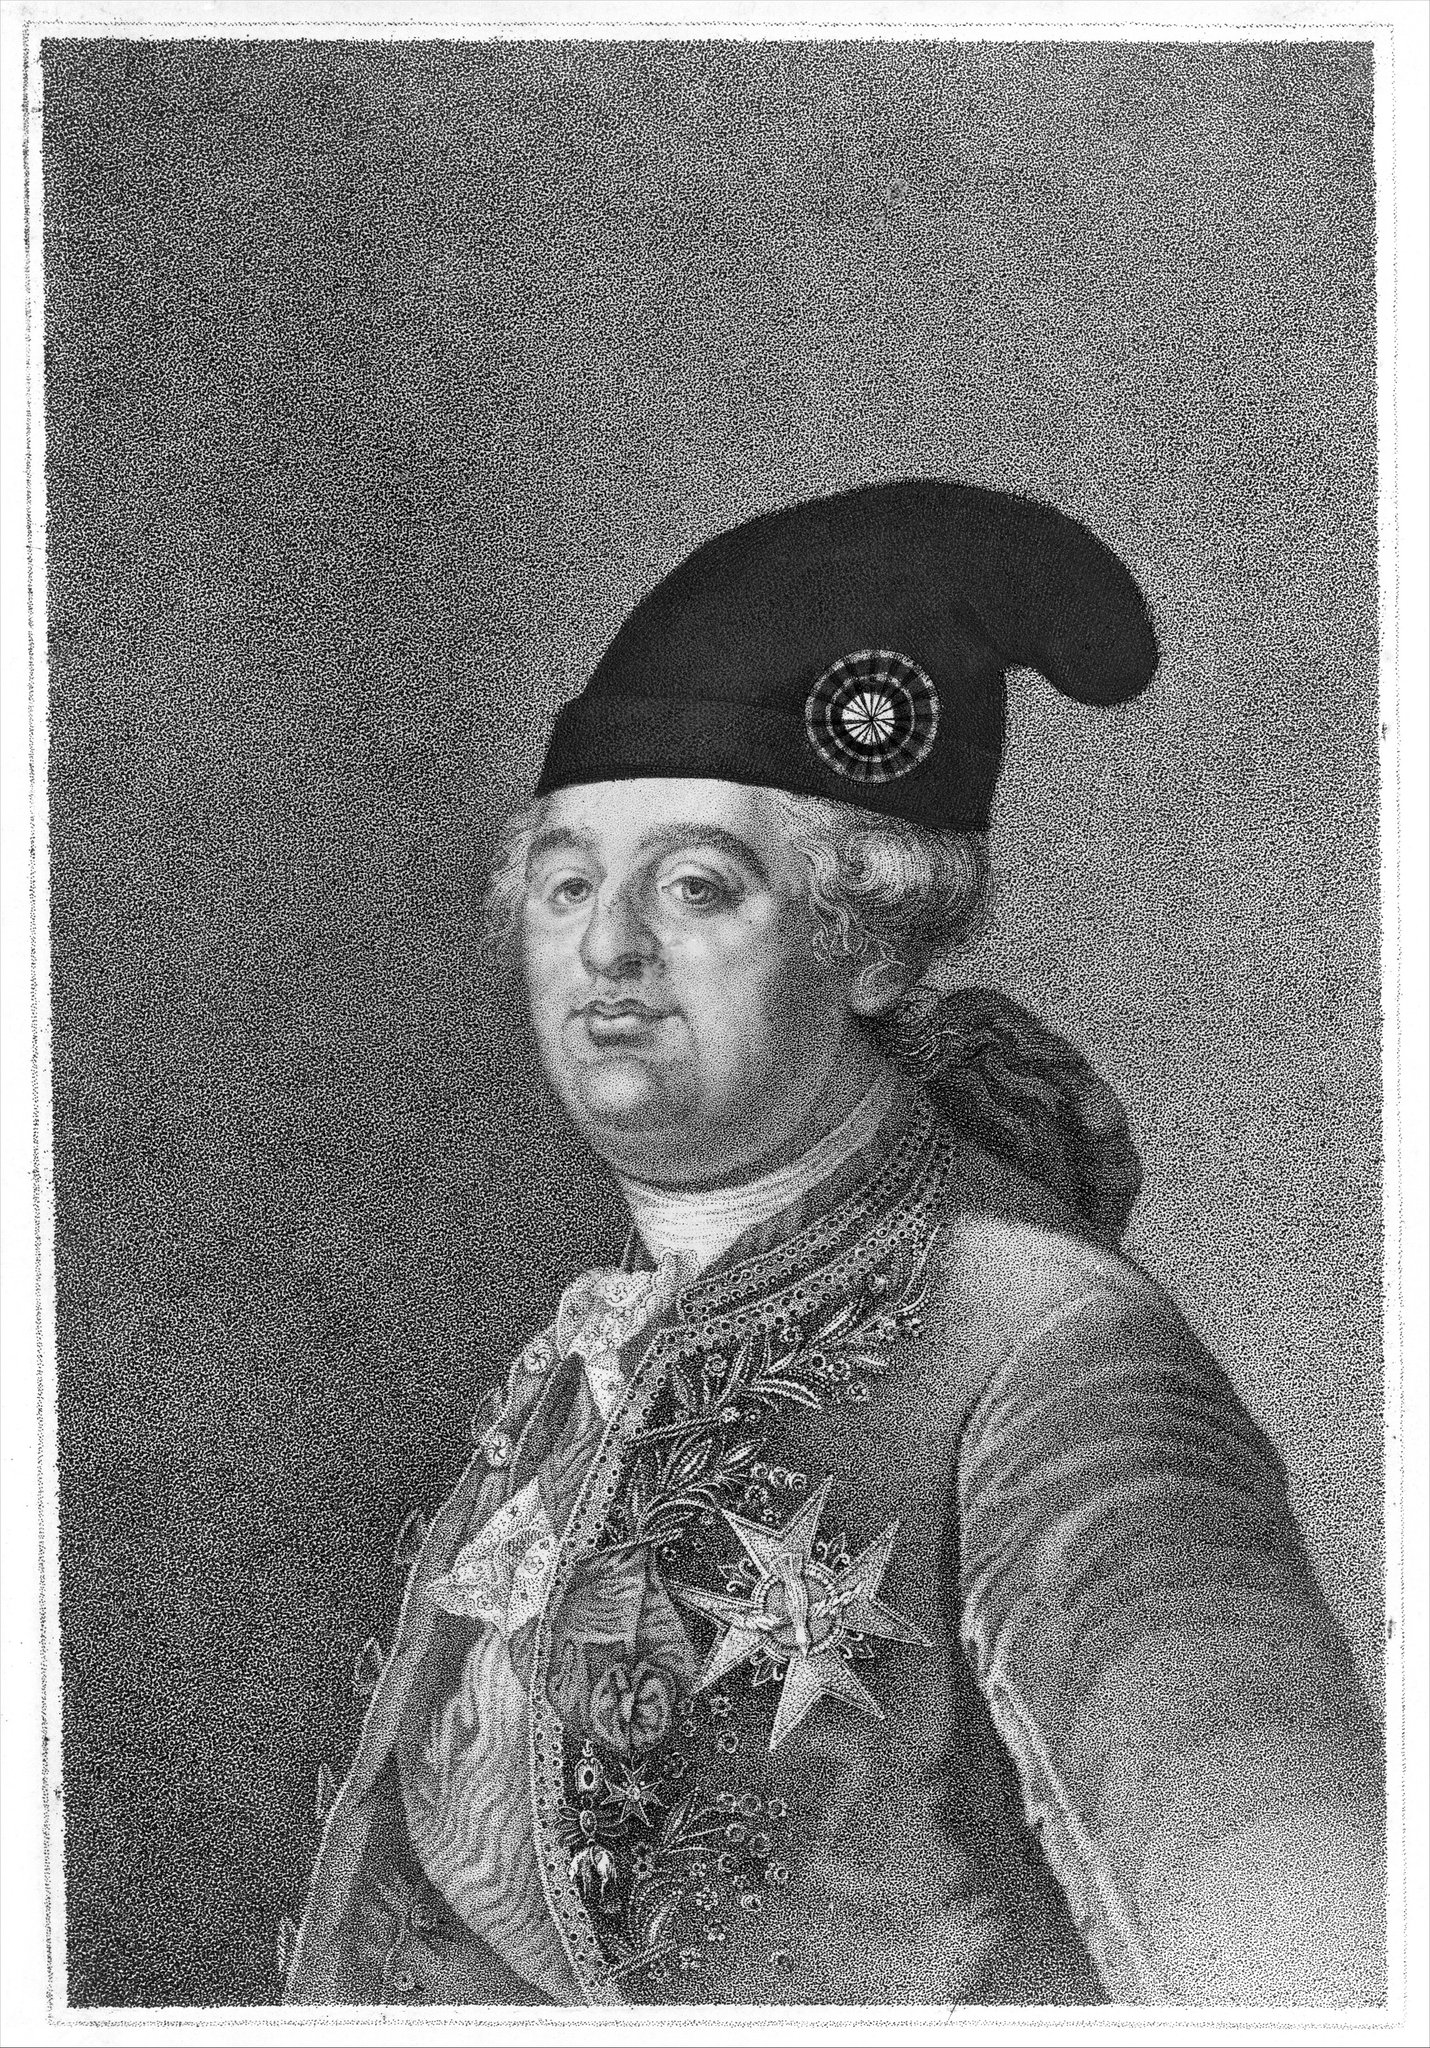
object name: print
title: Louis Seize Roi des Francais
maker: anonymous, french, 18th century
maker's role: artist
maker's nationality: french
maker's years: 1700-1800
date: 1701-1800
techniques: hand coloring, engraving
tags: kings,louis xvi,portraits